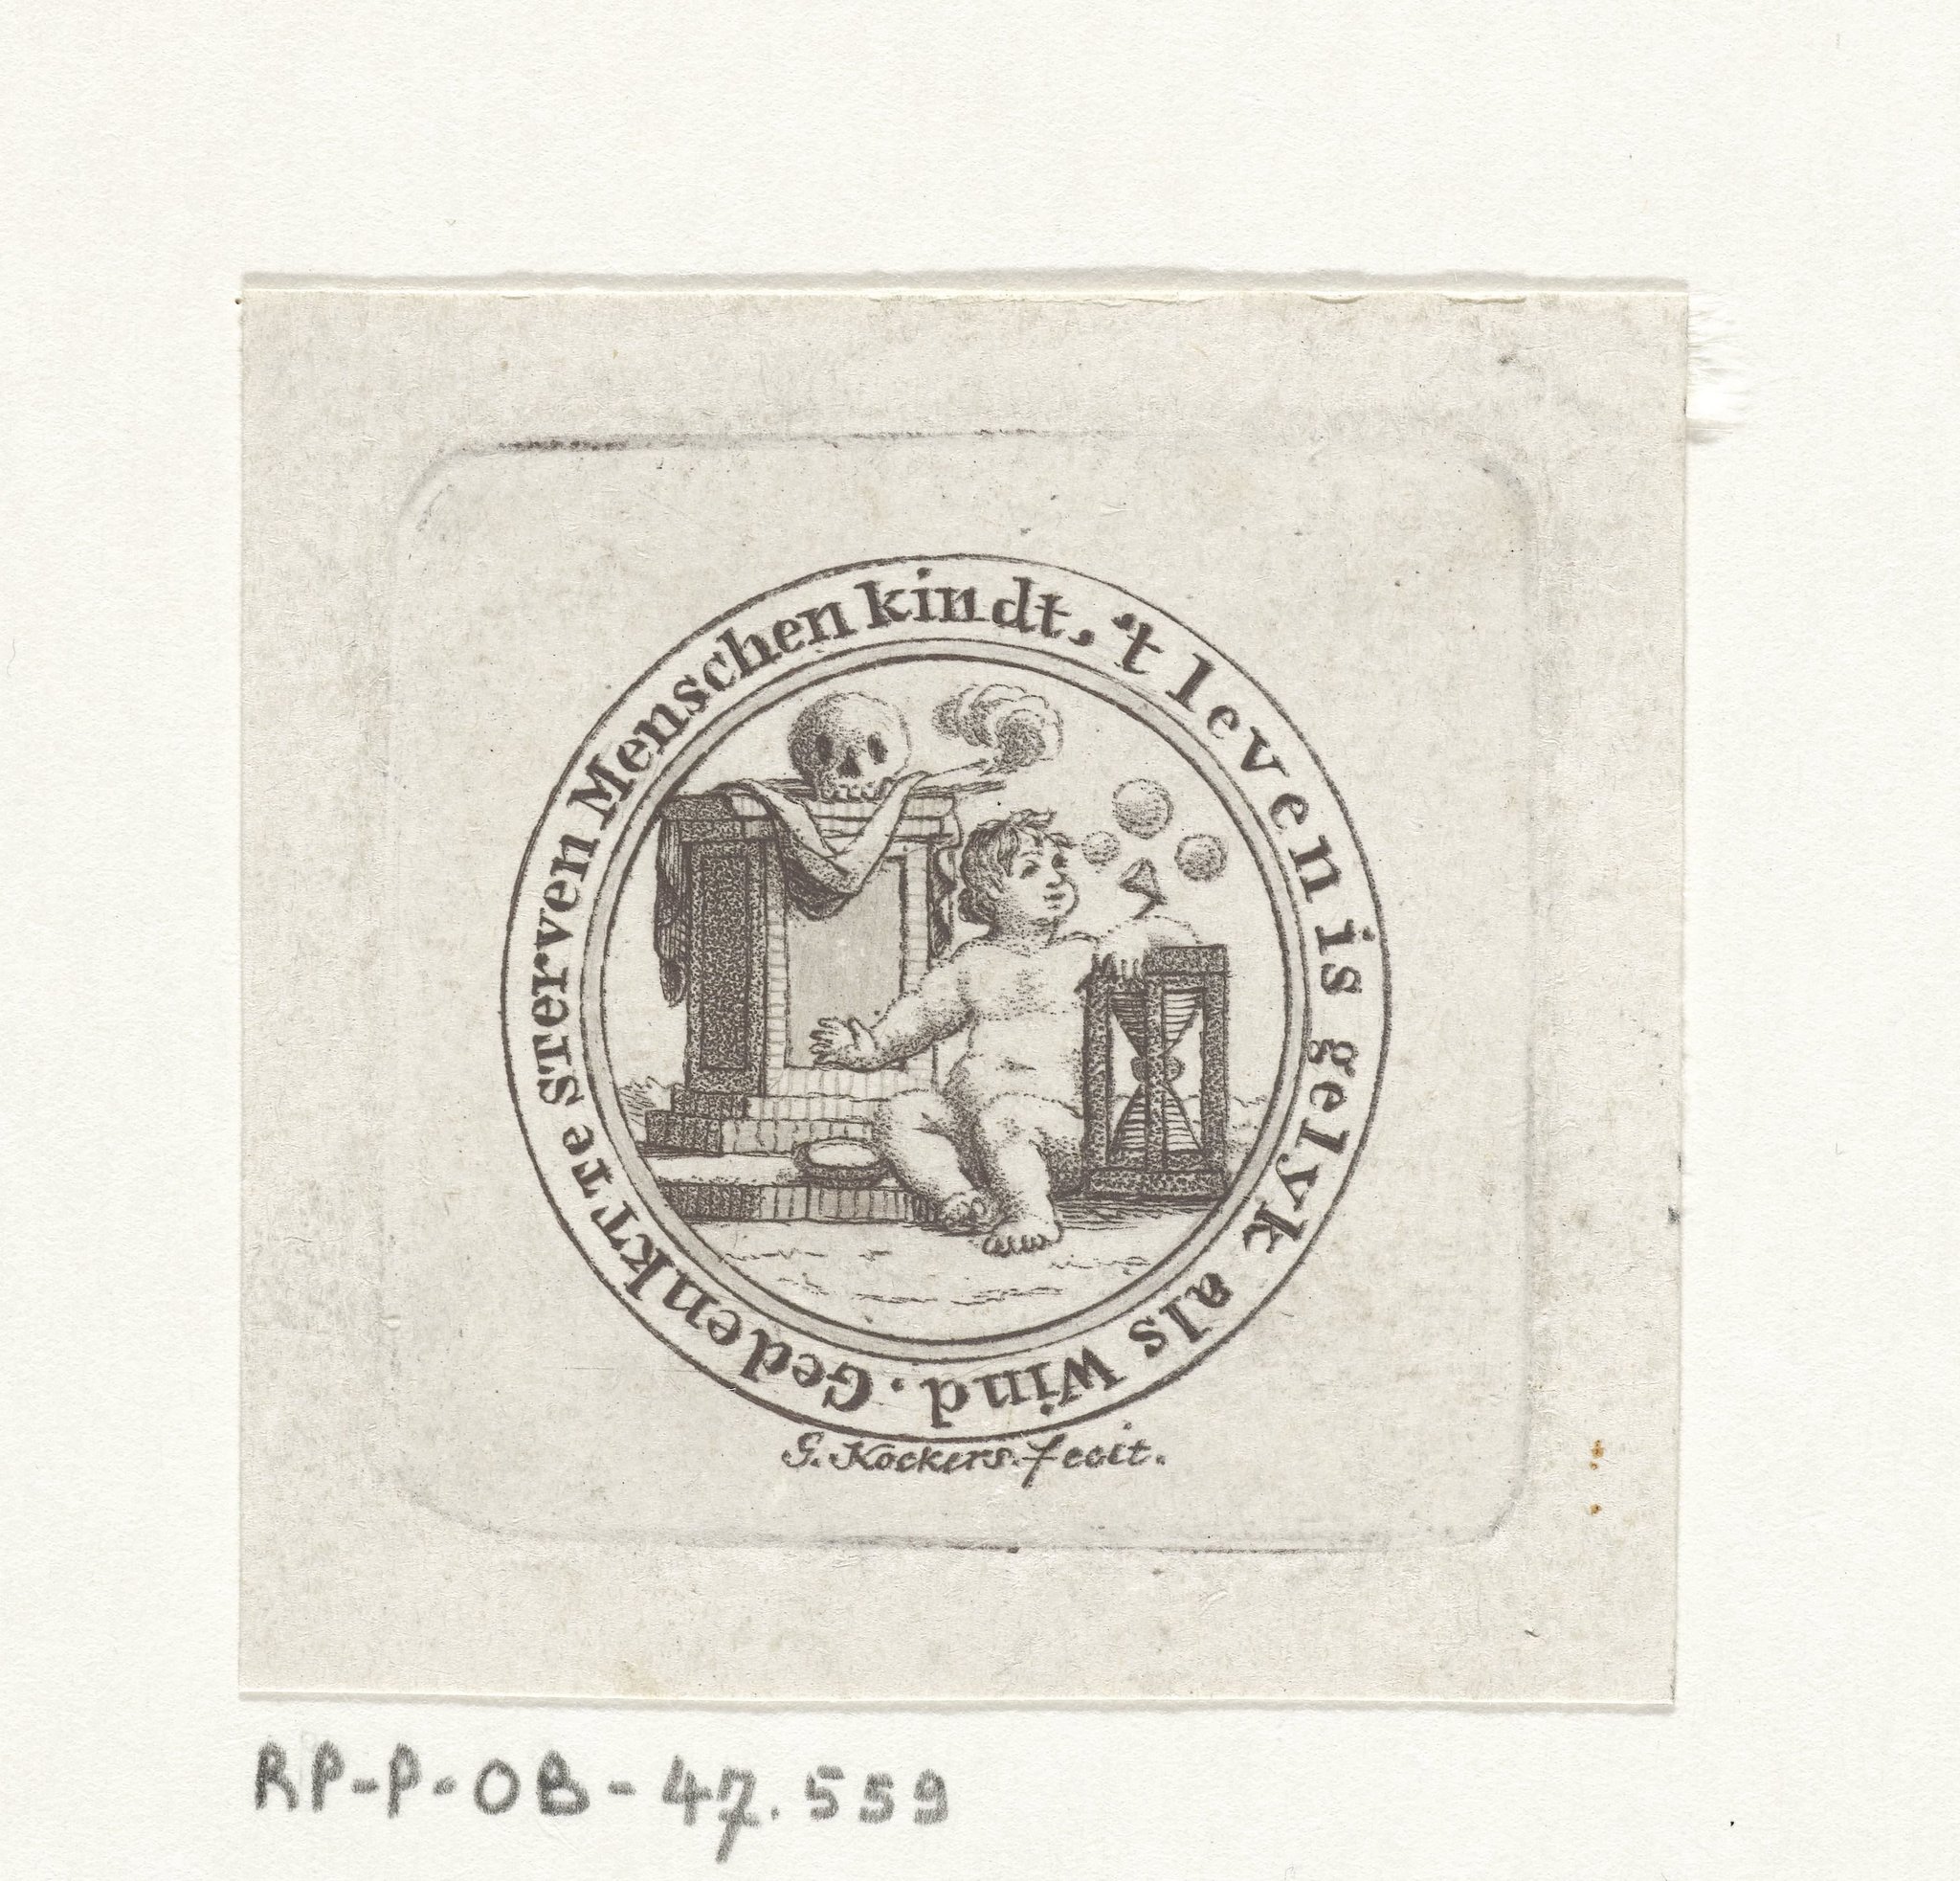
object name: print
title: Vanitas met bellen blazend kind, schedel en zandloper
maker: george kockers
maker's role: goldsmith, print maker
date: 1780-1810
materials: paper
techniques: etching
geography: middelburg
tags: (children or putti) blowing bubbles, 'homo bulla' ~ scene symbolizing 'vanitas' (+ holy trinity), (human) skull, hourglass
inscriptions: collector's mark: Lugt 2228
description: Cirkelvormige vanitas voor in een zakhorloge. Bij een graftombe waarop een schedel ligt zit een bellen blazend kind, de linkerarm leunend op een zandloper. In de cirkelvormige omlijsting de spreuk: Gedenkt te sterven Menschen kindt, -'t leven is gelyk als Wind.